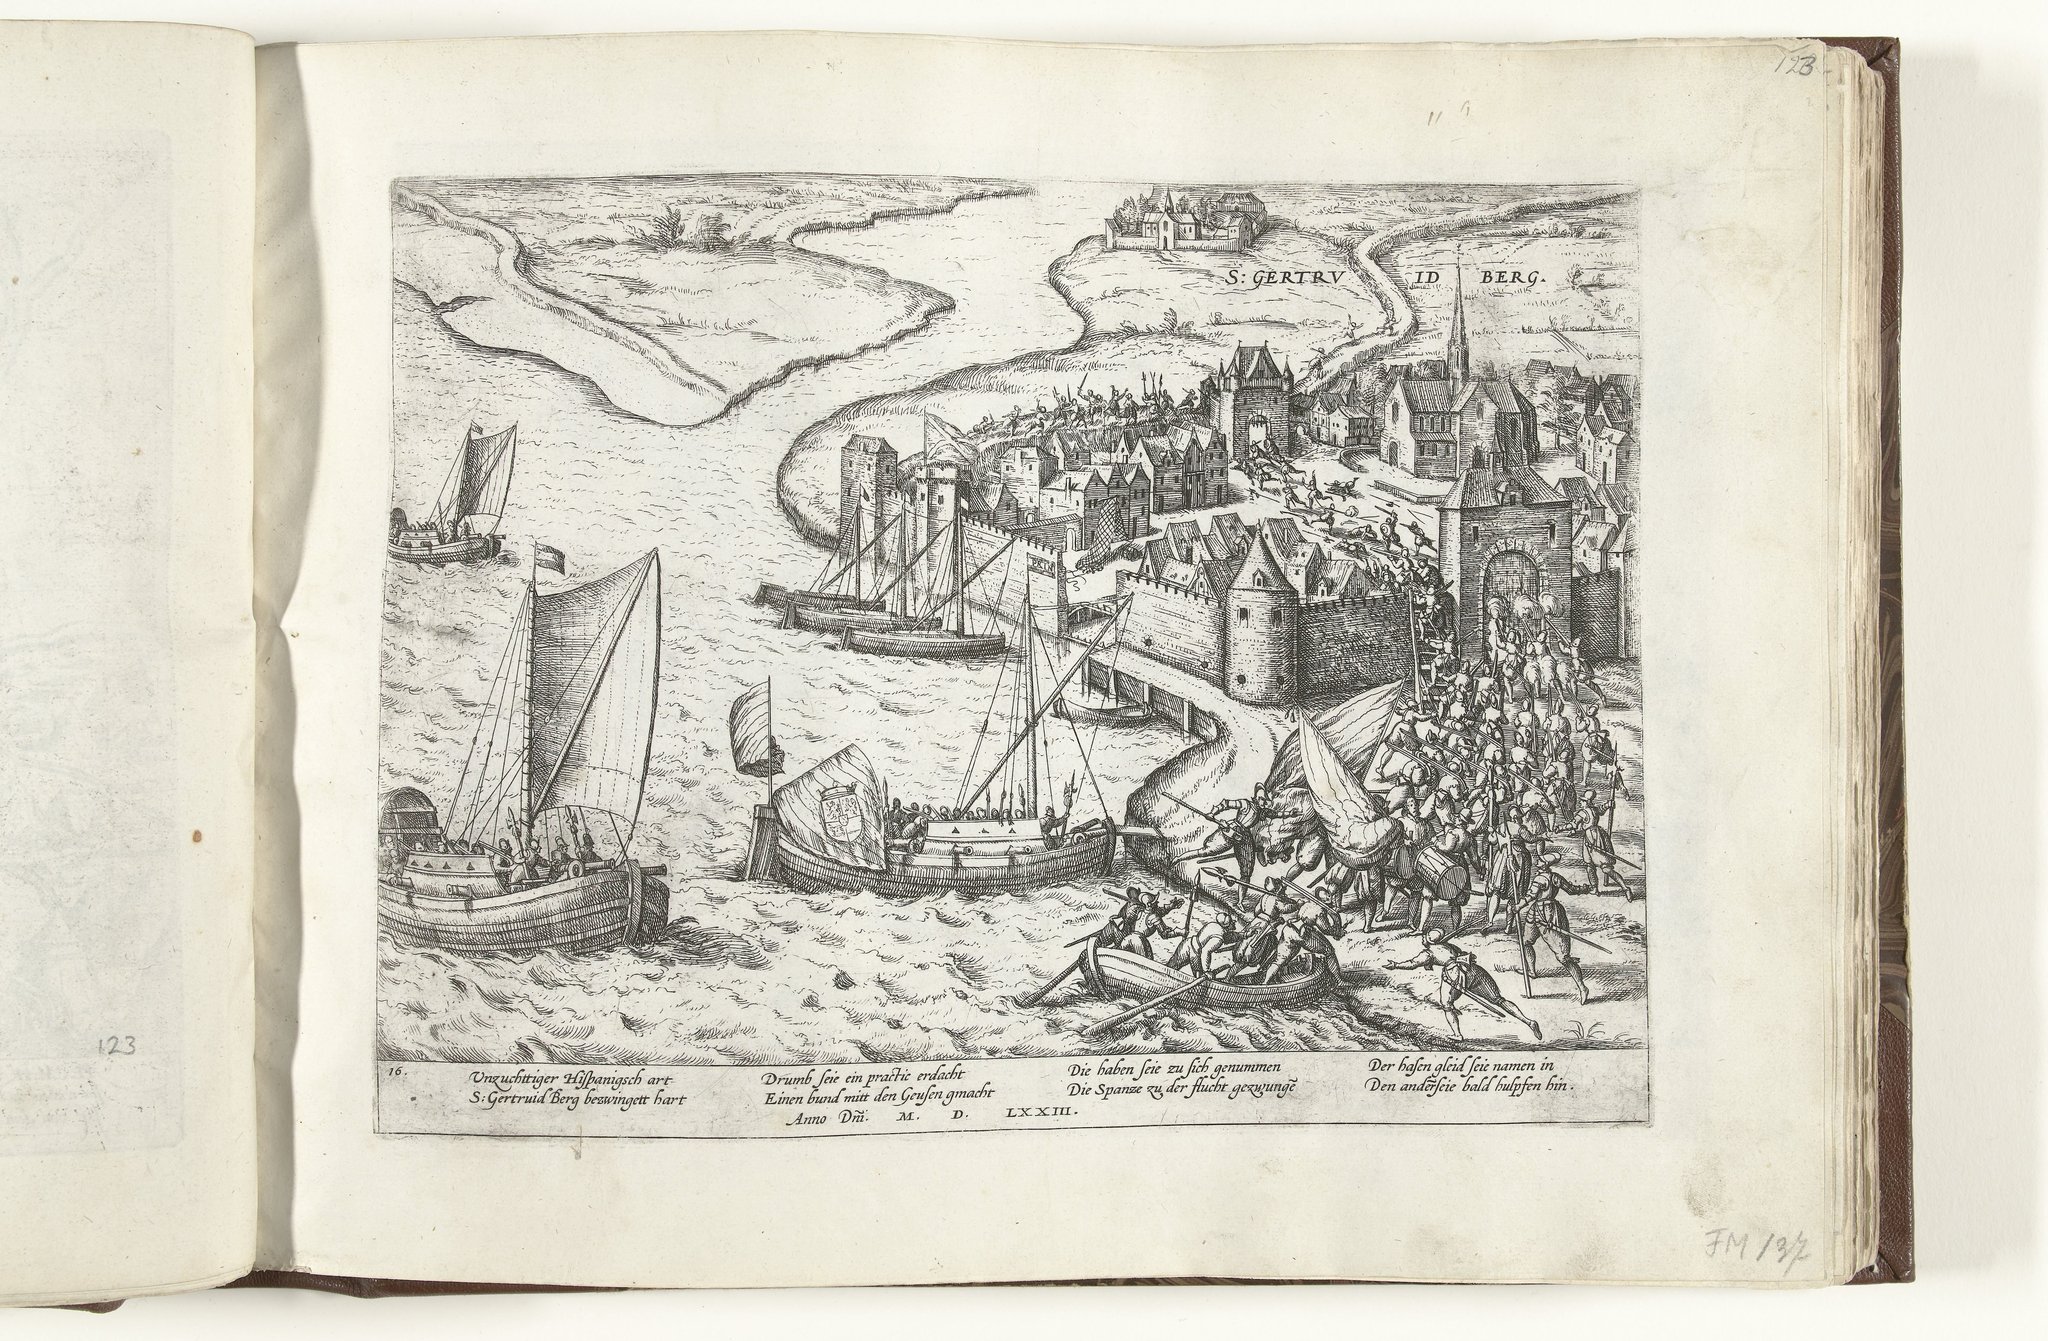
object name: album leaf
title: Inname van Geertruidenberg, 1573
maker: frans hogenberg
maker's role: print maker, publisher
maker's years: 1538-1590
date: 1573-1575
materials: paper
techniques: etching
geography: cologne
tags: capture of city (after the siege), geertruidenberg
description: Inname van Geertruidenberg door de watergeuzen op 28 augustus 1573. Soldaten komen op de voorgrond aan land en bestormen de stad. In het water enkele kleine schepen met vlaggen. Met onderschrift van 8 regels in het Duits. Genummerd: 16.